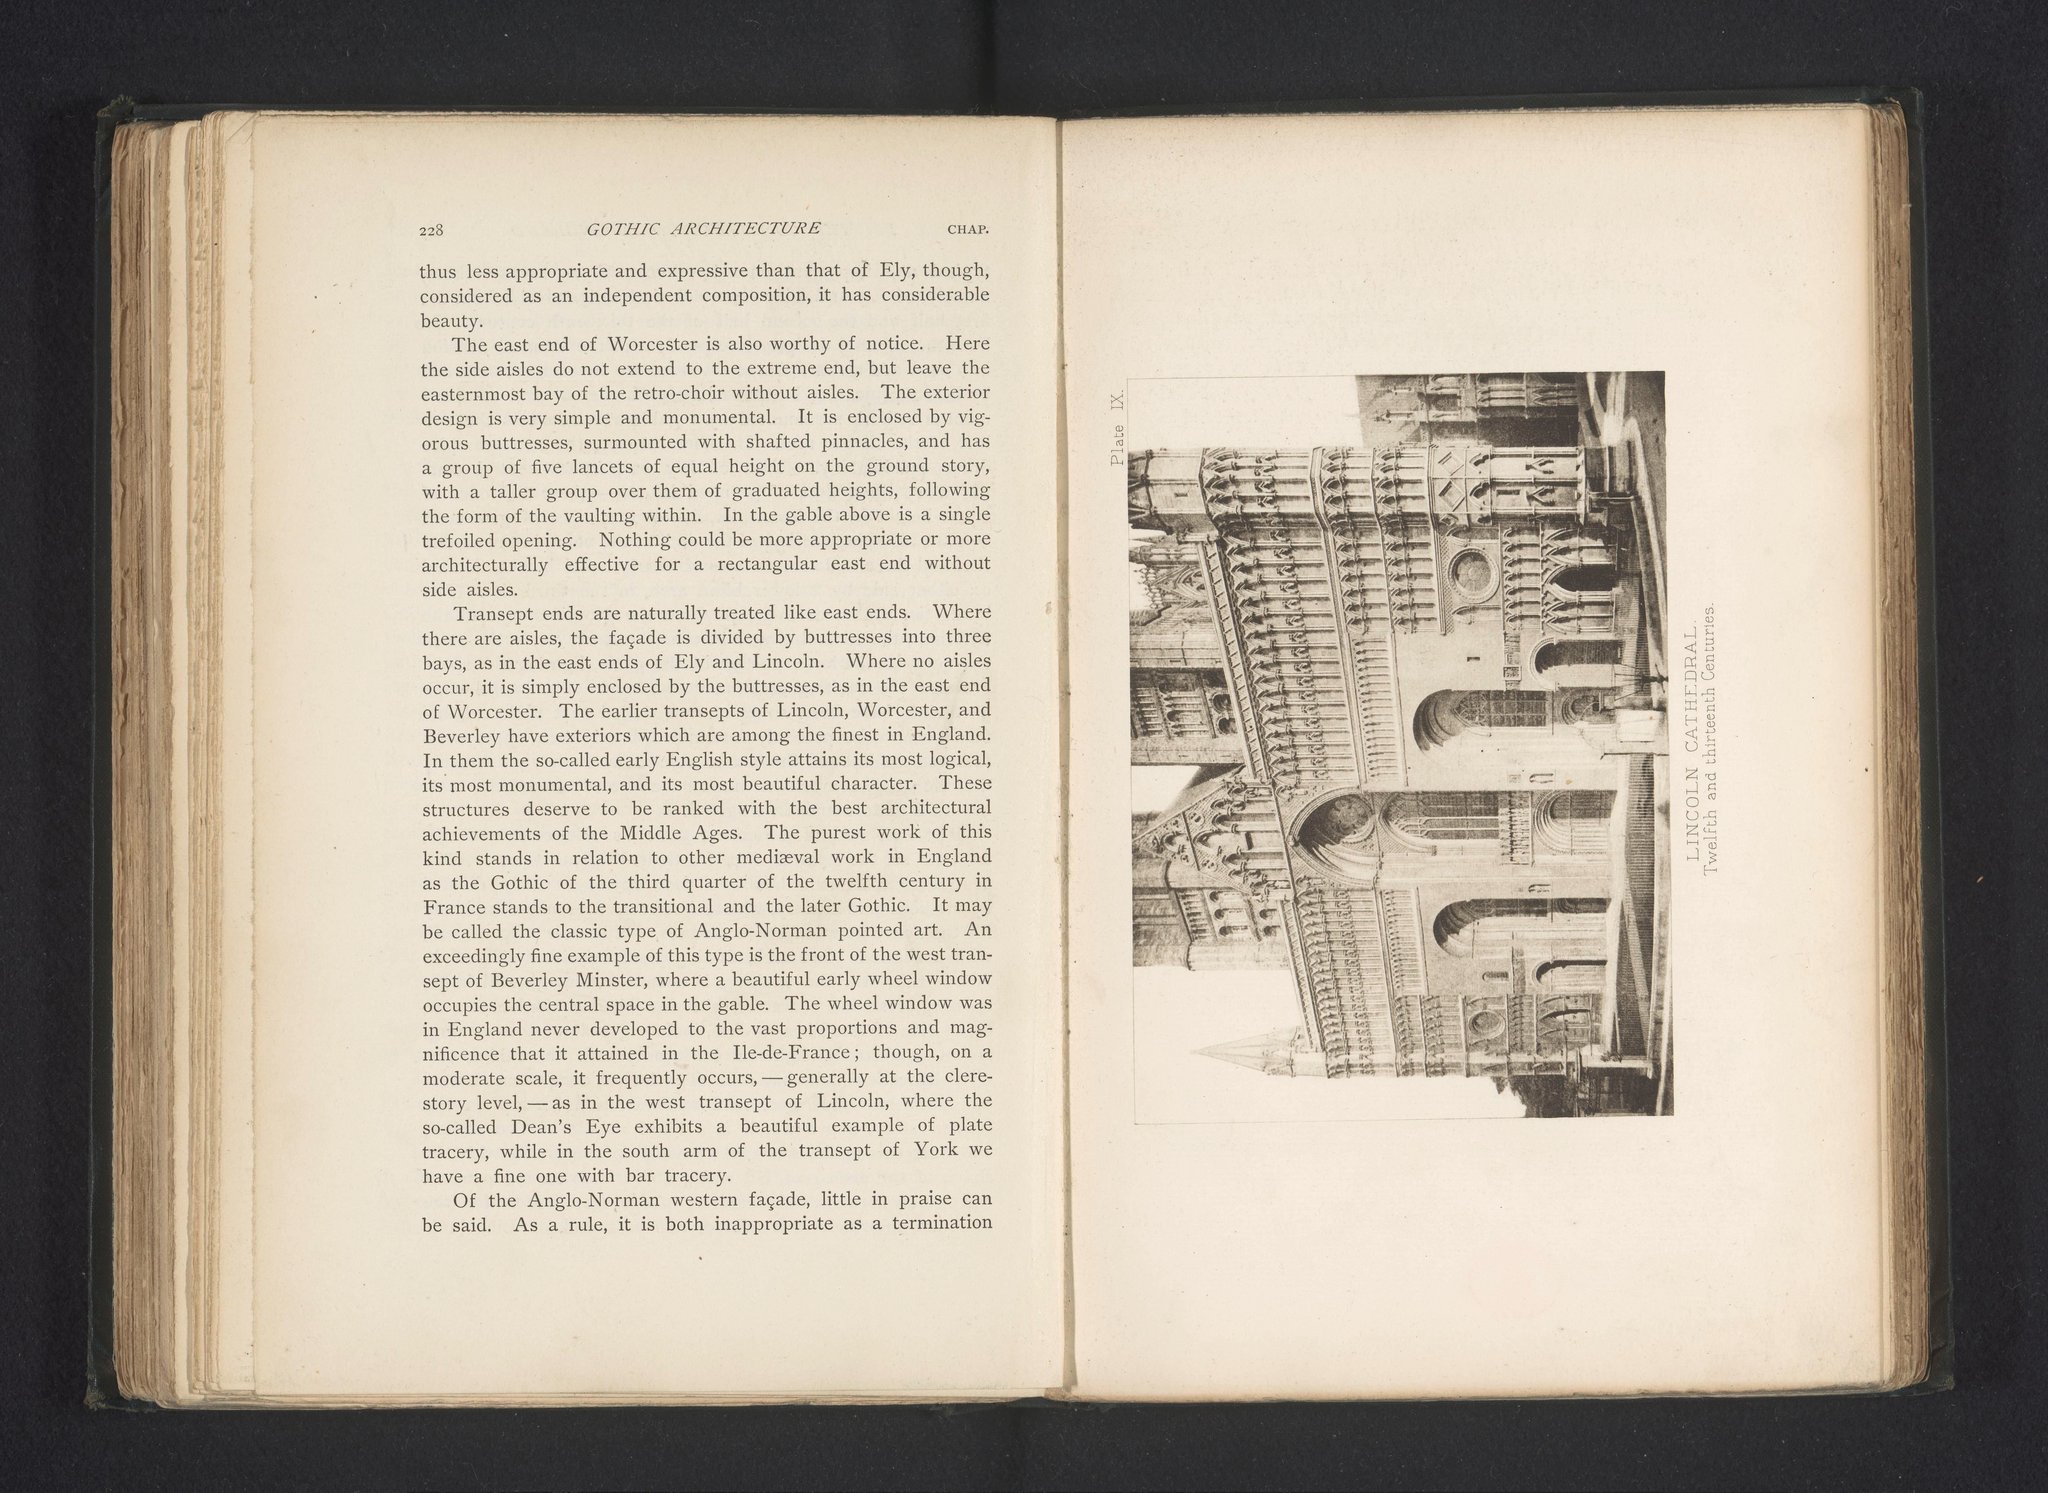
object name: photomechanical print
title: Lincoln Cathedral. Twelfth and thirteenth Centuries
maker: Anonymous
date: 1880-1890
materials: paper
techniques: photoaquatint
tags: church (exterior), parts of church exterior and annexes: façade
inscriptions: name: ‘National Art Library’, number: ‘PLate IX.’